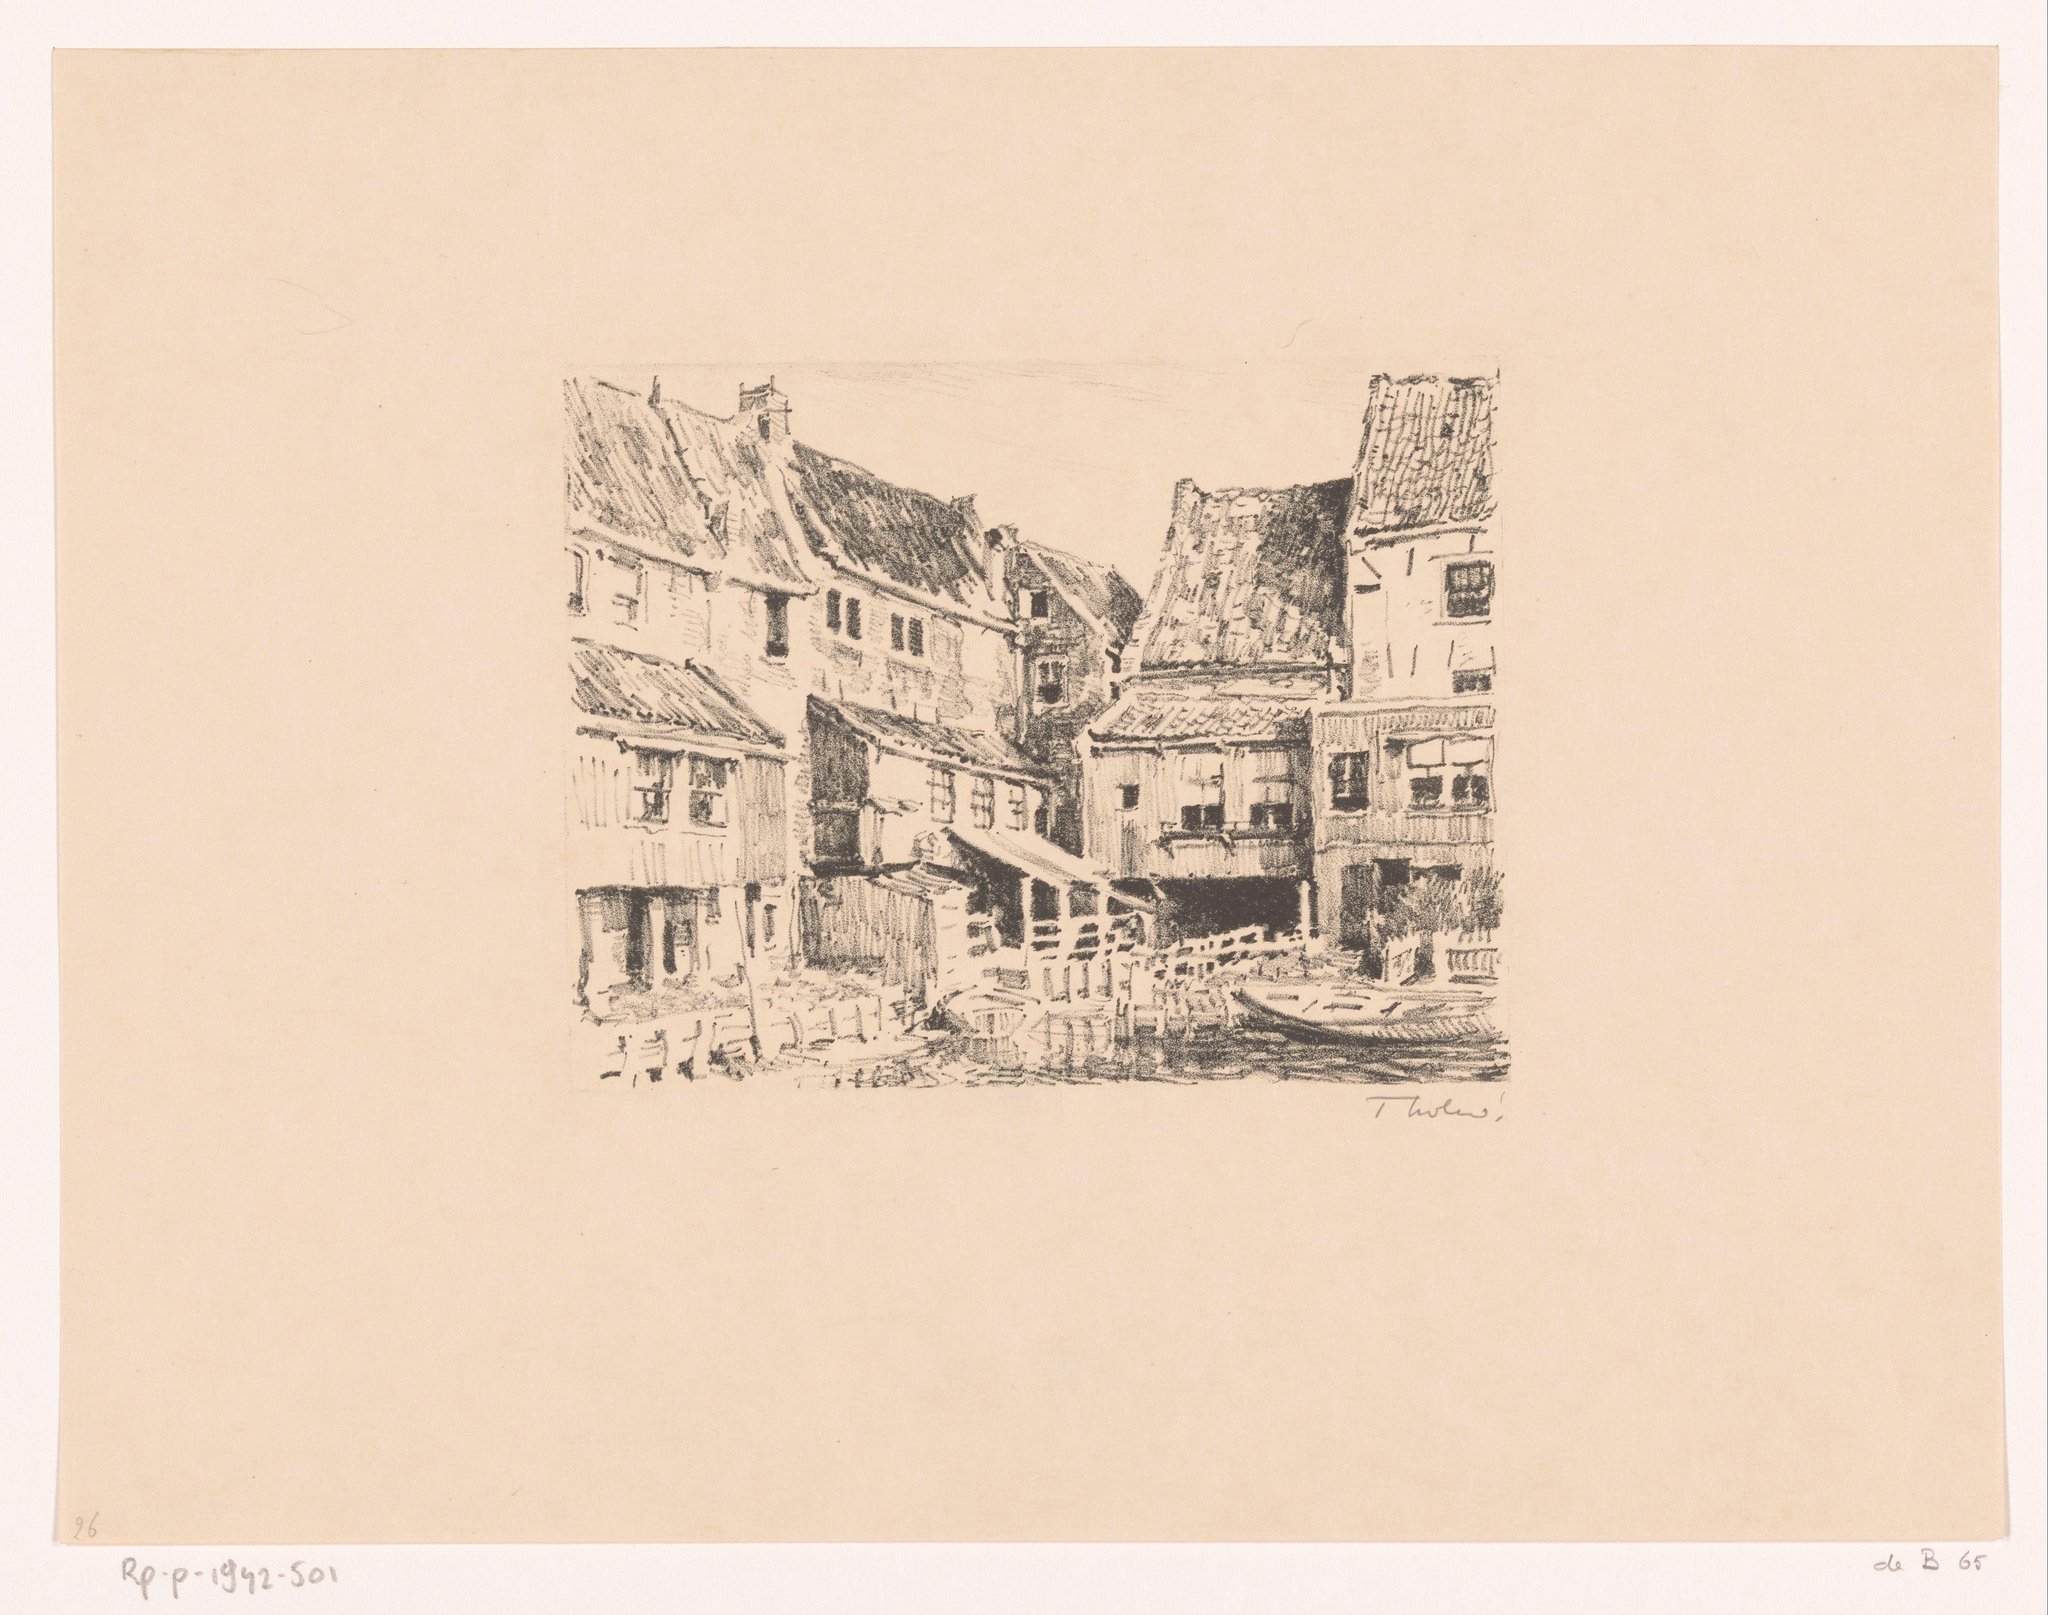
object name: print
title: Achterkant van oude huizen, te Enkhuizen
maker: willem bastiaan tholen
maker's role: draughtsman, painter, print maker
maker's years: 1860-1931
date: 1870-1914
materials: paper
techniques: lithograph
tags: urban housing, rowing-boat, canoe, etc., enkhuizen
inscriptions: collector's mark: Lugt 2228